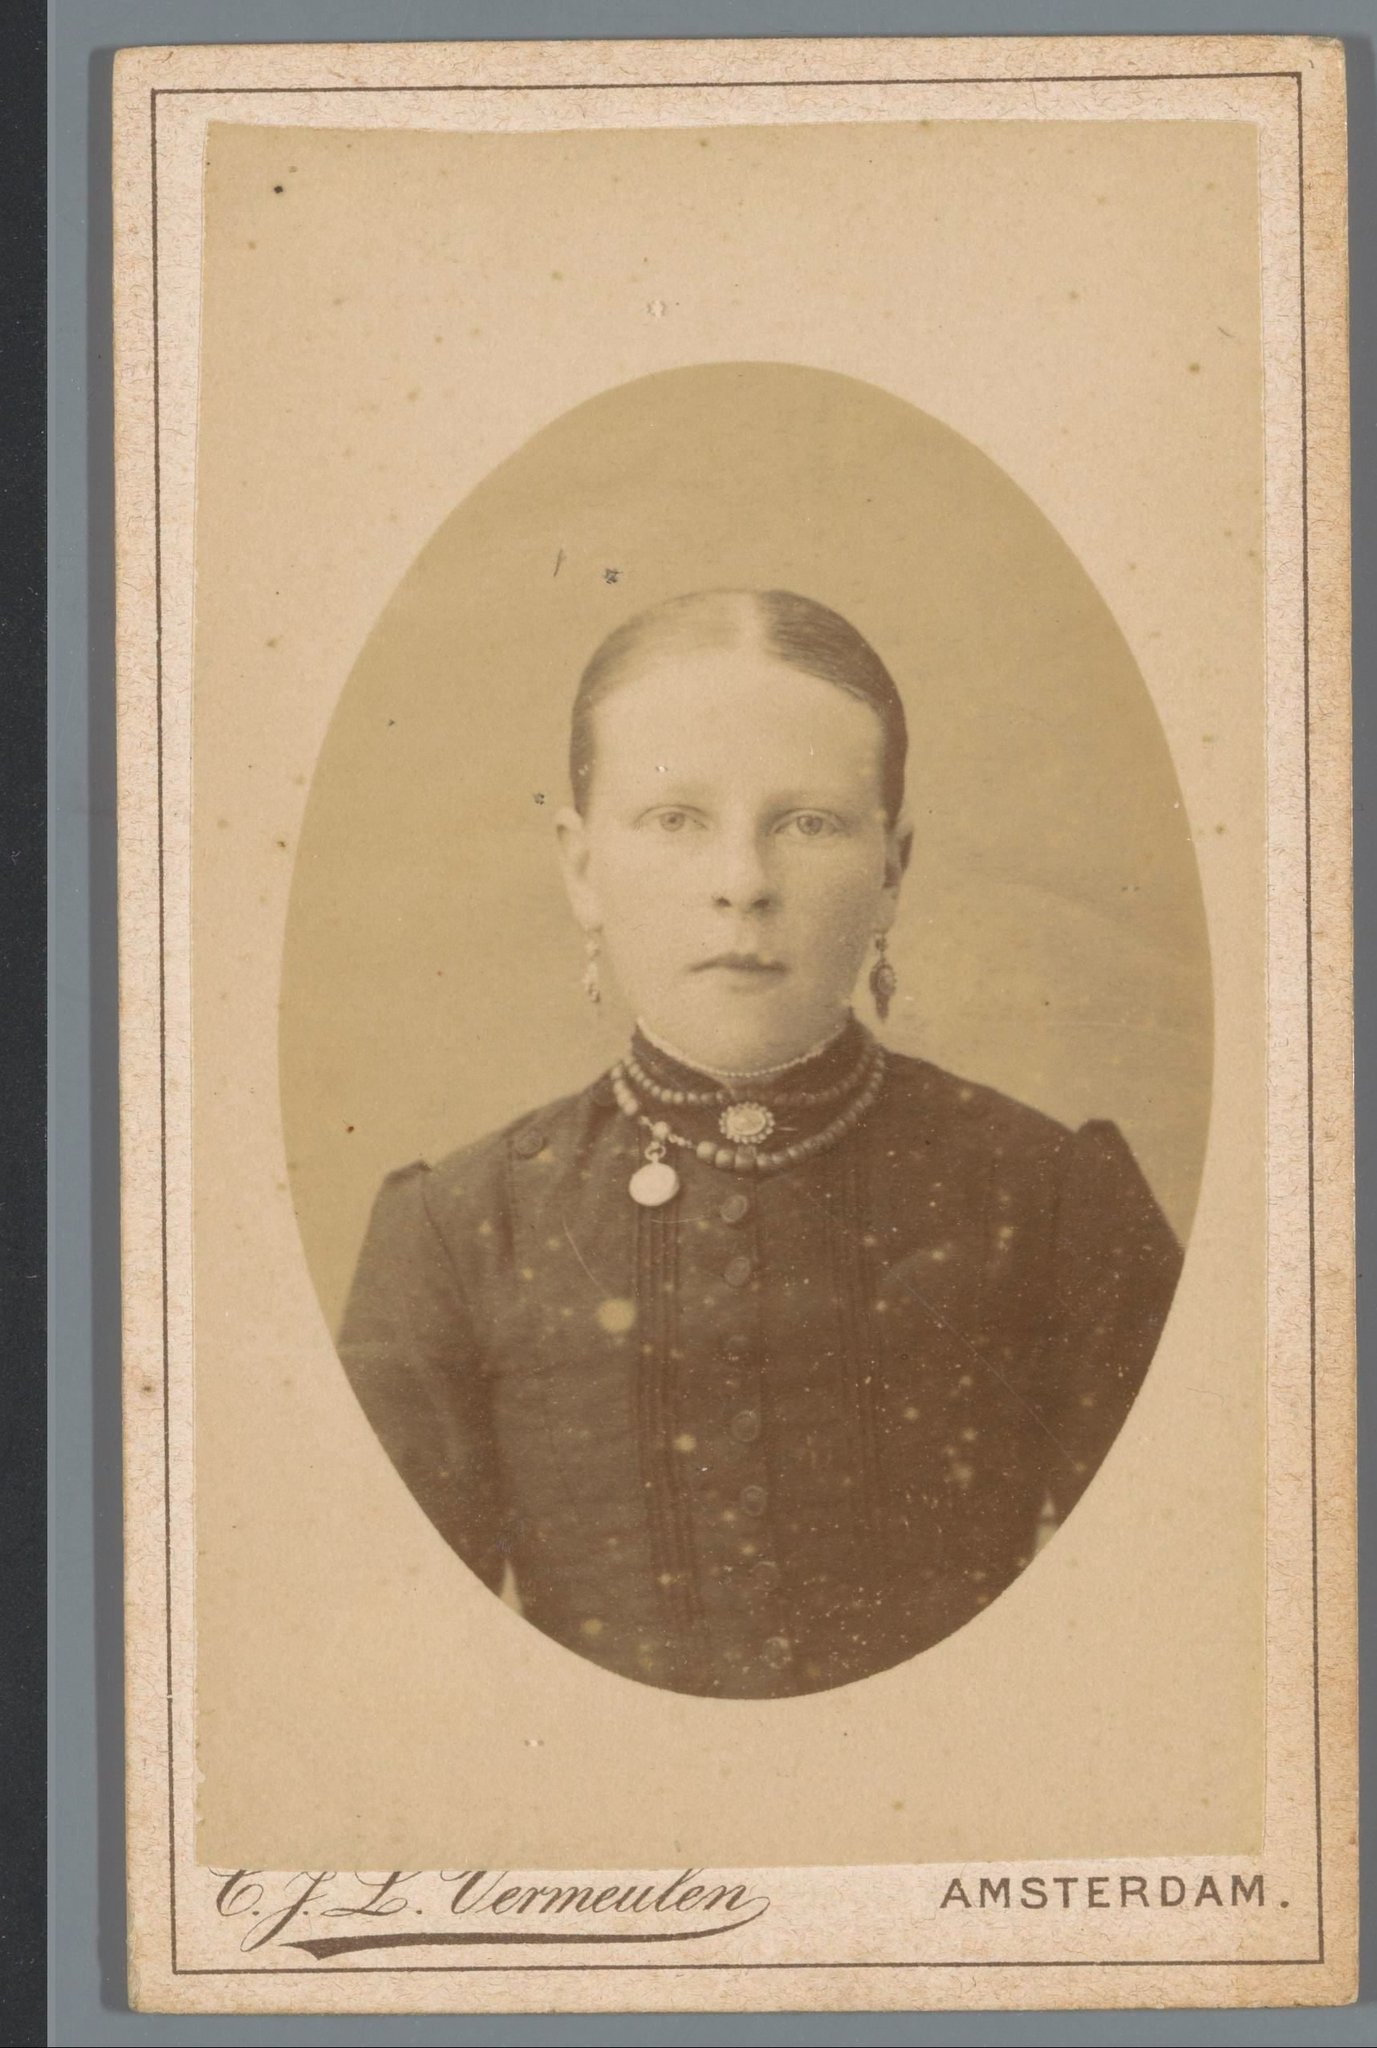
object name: photograph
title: Portret van een onbekende jonge vrouw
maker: cornelis johannes lodewicus vermeulen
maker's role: fotograaf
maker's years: 1861-1936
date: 1888-1896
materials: cardboard, paper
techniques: albumen print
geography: amsterdam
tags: adolescent, young woman, maiden, anonymous historical person portrayed, amsterdam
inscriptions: address: ‘Heerenstraat 6,/ &/ Heiligenweg/ hoek Singel/ Amsterdam.’, inscription: ‘Specialiteit in vergrootingen.’